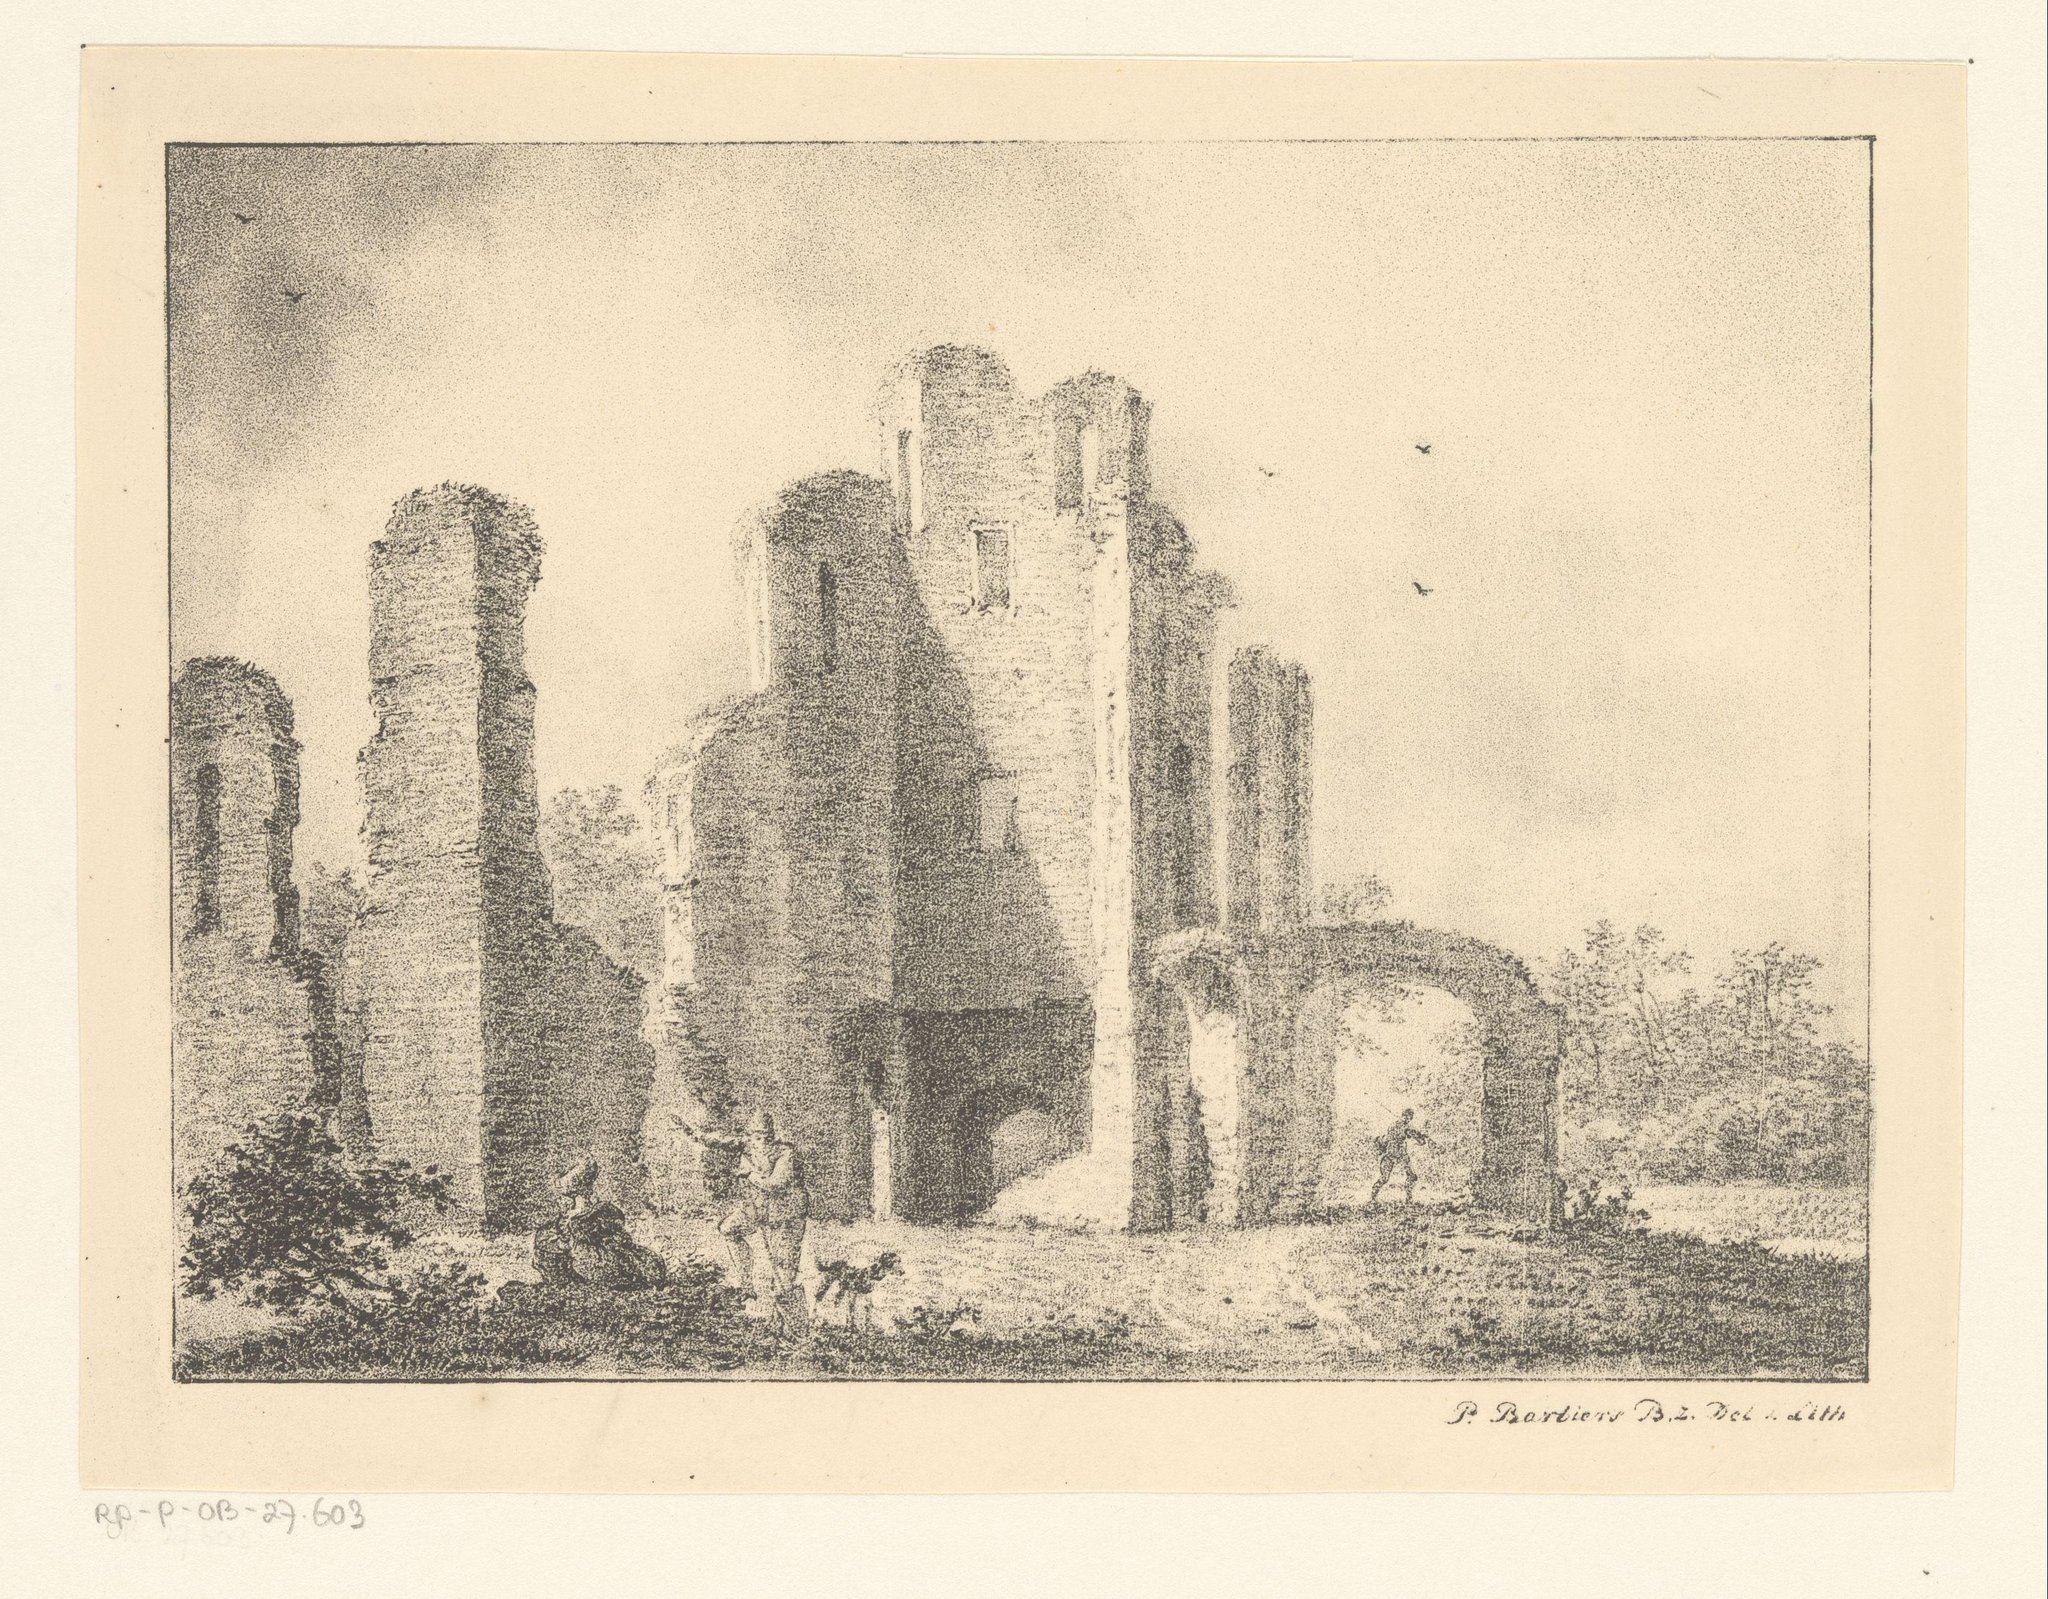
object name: print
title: Landschap met ruïne en figuren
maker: pieter bartholomeusz. barbiers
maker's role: draughtsman, print maker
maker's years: 1772-1837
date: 1809-1837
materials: paper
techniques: lithograph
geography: haarlem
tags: landscape with ruins, landscapes (+ landscape with figures, staffage)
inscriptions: collector's mark: Lugt 2228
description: Linksvoor zit een vrouw op de grond. Naast haar staat een man die zijn arm in de lucht steekt. Hij leunt op een spade. Daarnaast een hond. Een derde figuur loopt door de ruïne heen. In de lucht enkele vogels.